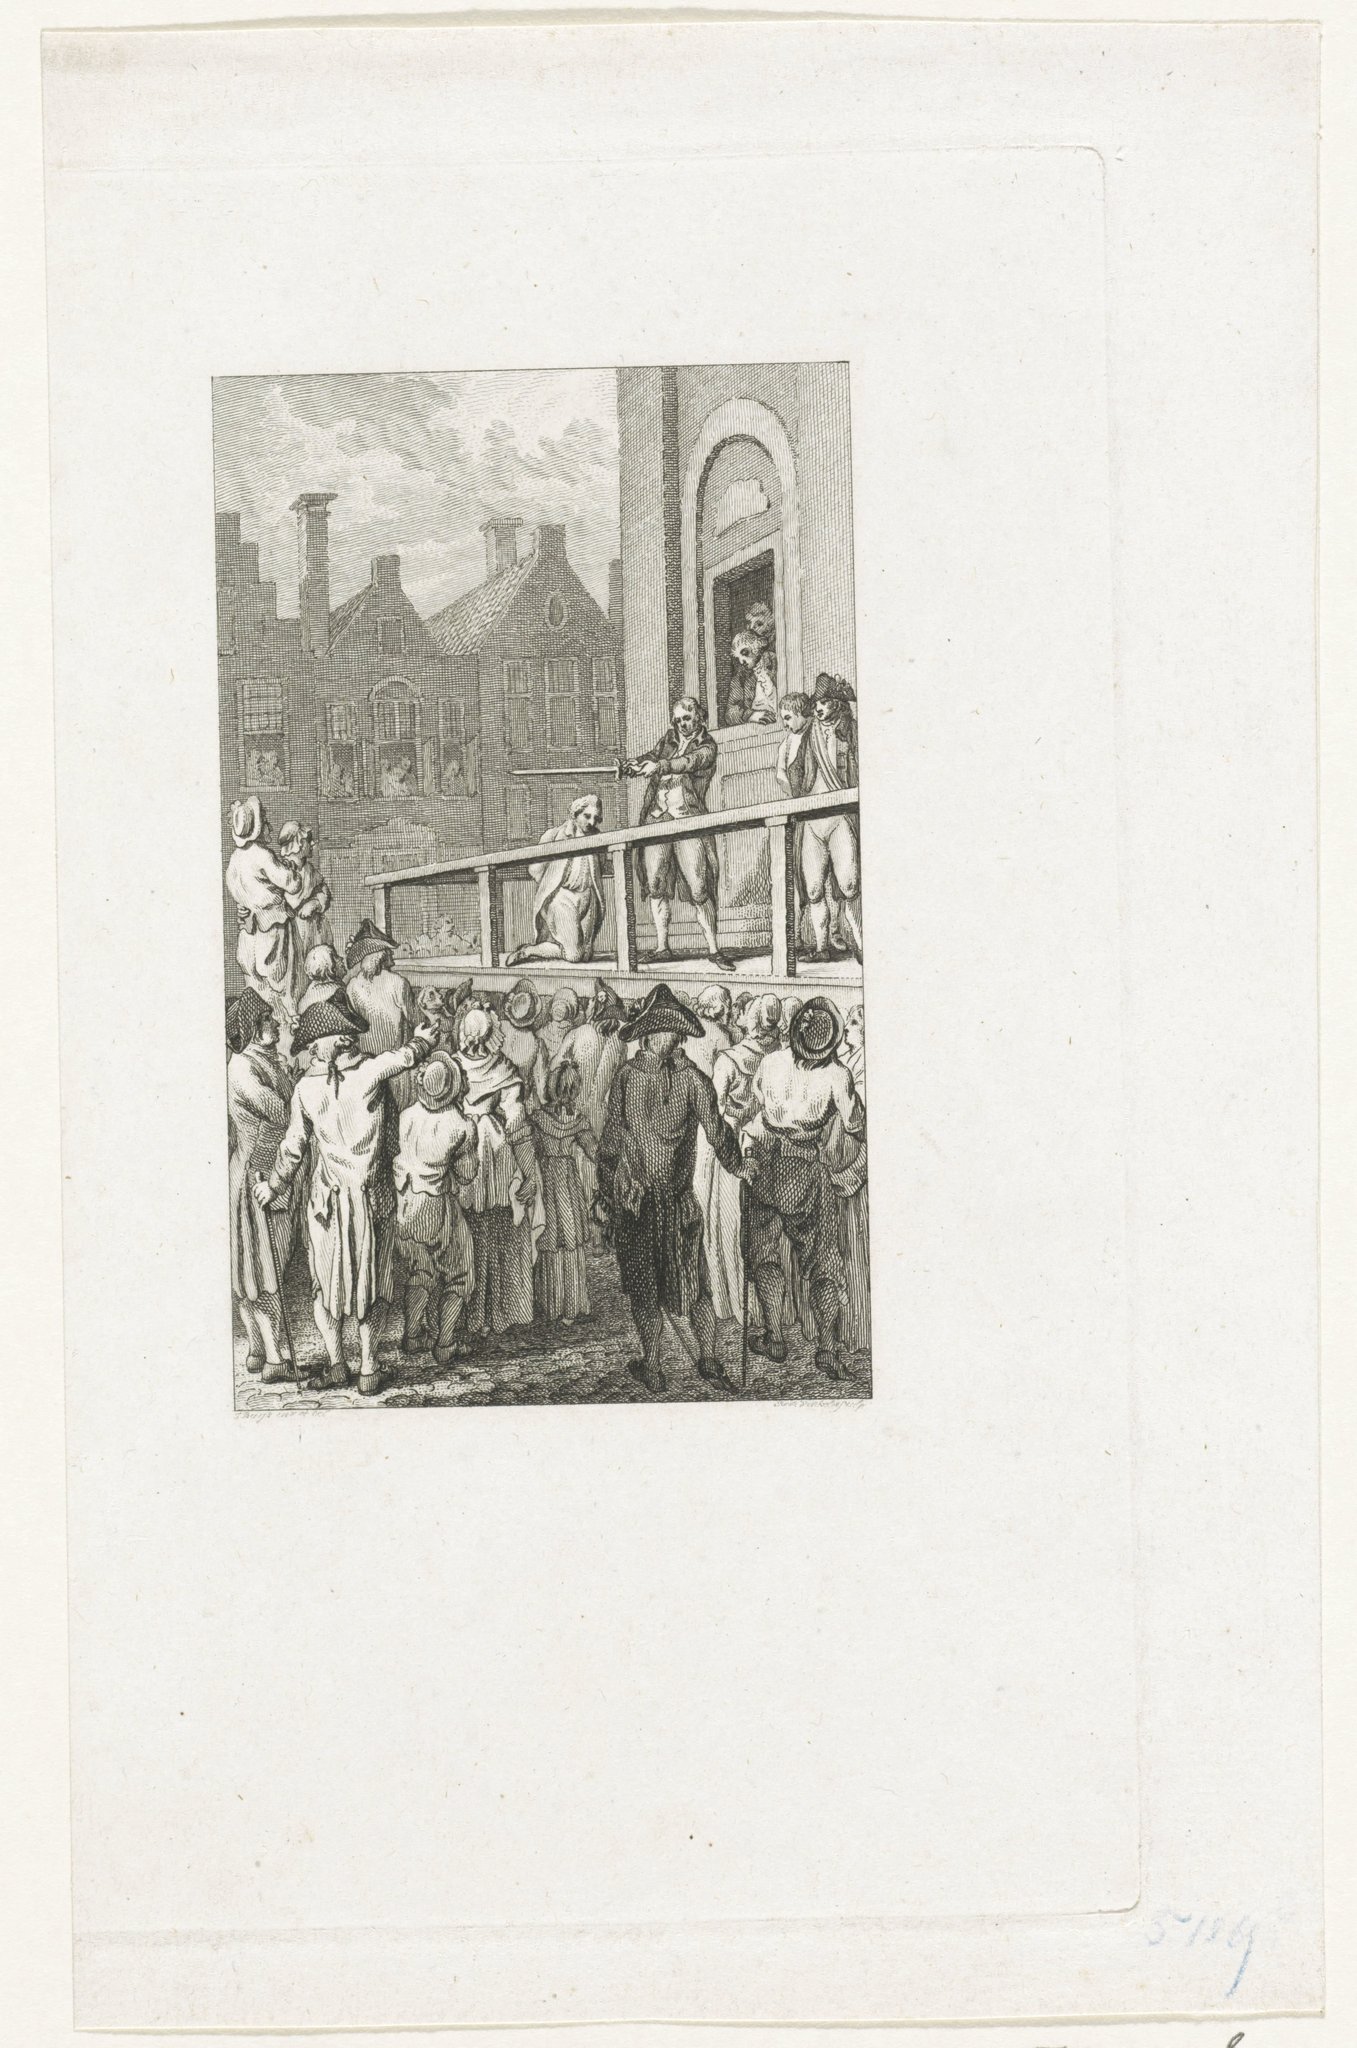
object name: print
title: Terechtstelling van burgemeester Cornelis van der Burgh te Leeuwarden, 1789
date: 1799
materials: paper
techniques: engraving, etching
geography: northern netherlands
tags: pardon, reprieve, violent death by hanging, patriots (1780-1795)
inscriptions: collector's mark: Lugt 2228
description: Terechtstelling van Cornelis van der Burg, uitgesproken patriotse burgemeester van Bolsward, te Leeuwarden op 16 mei 1789. Als de burgemeester knielt op het schavot houdt de beul het zwaard boven zijn hoofd en wordt het doodsvonnis omgezet in een verbanning van twintig jaar.